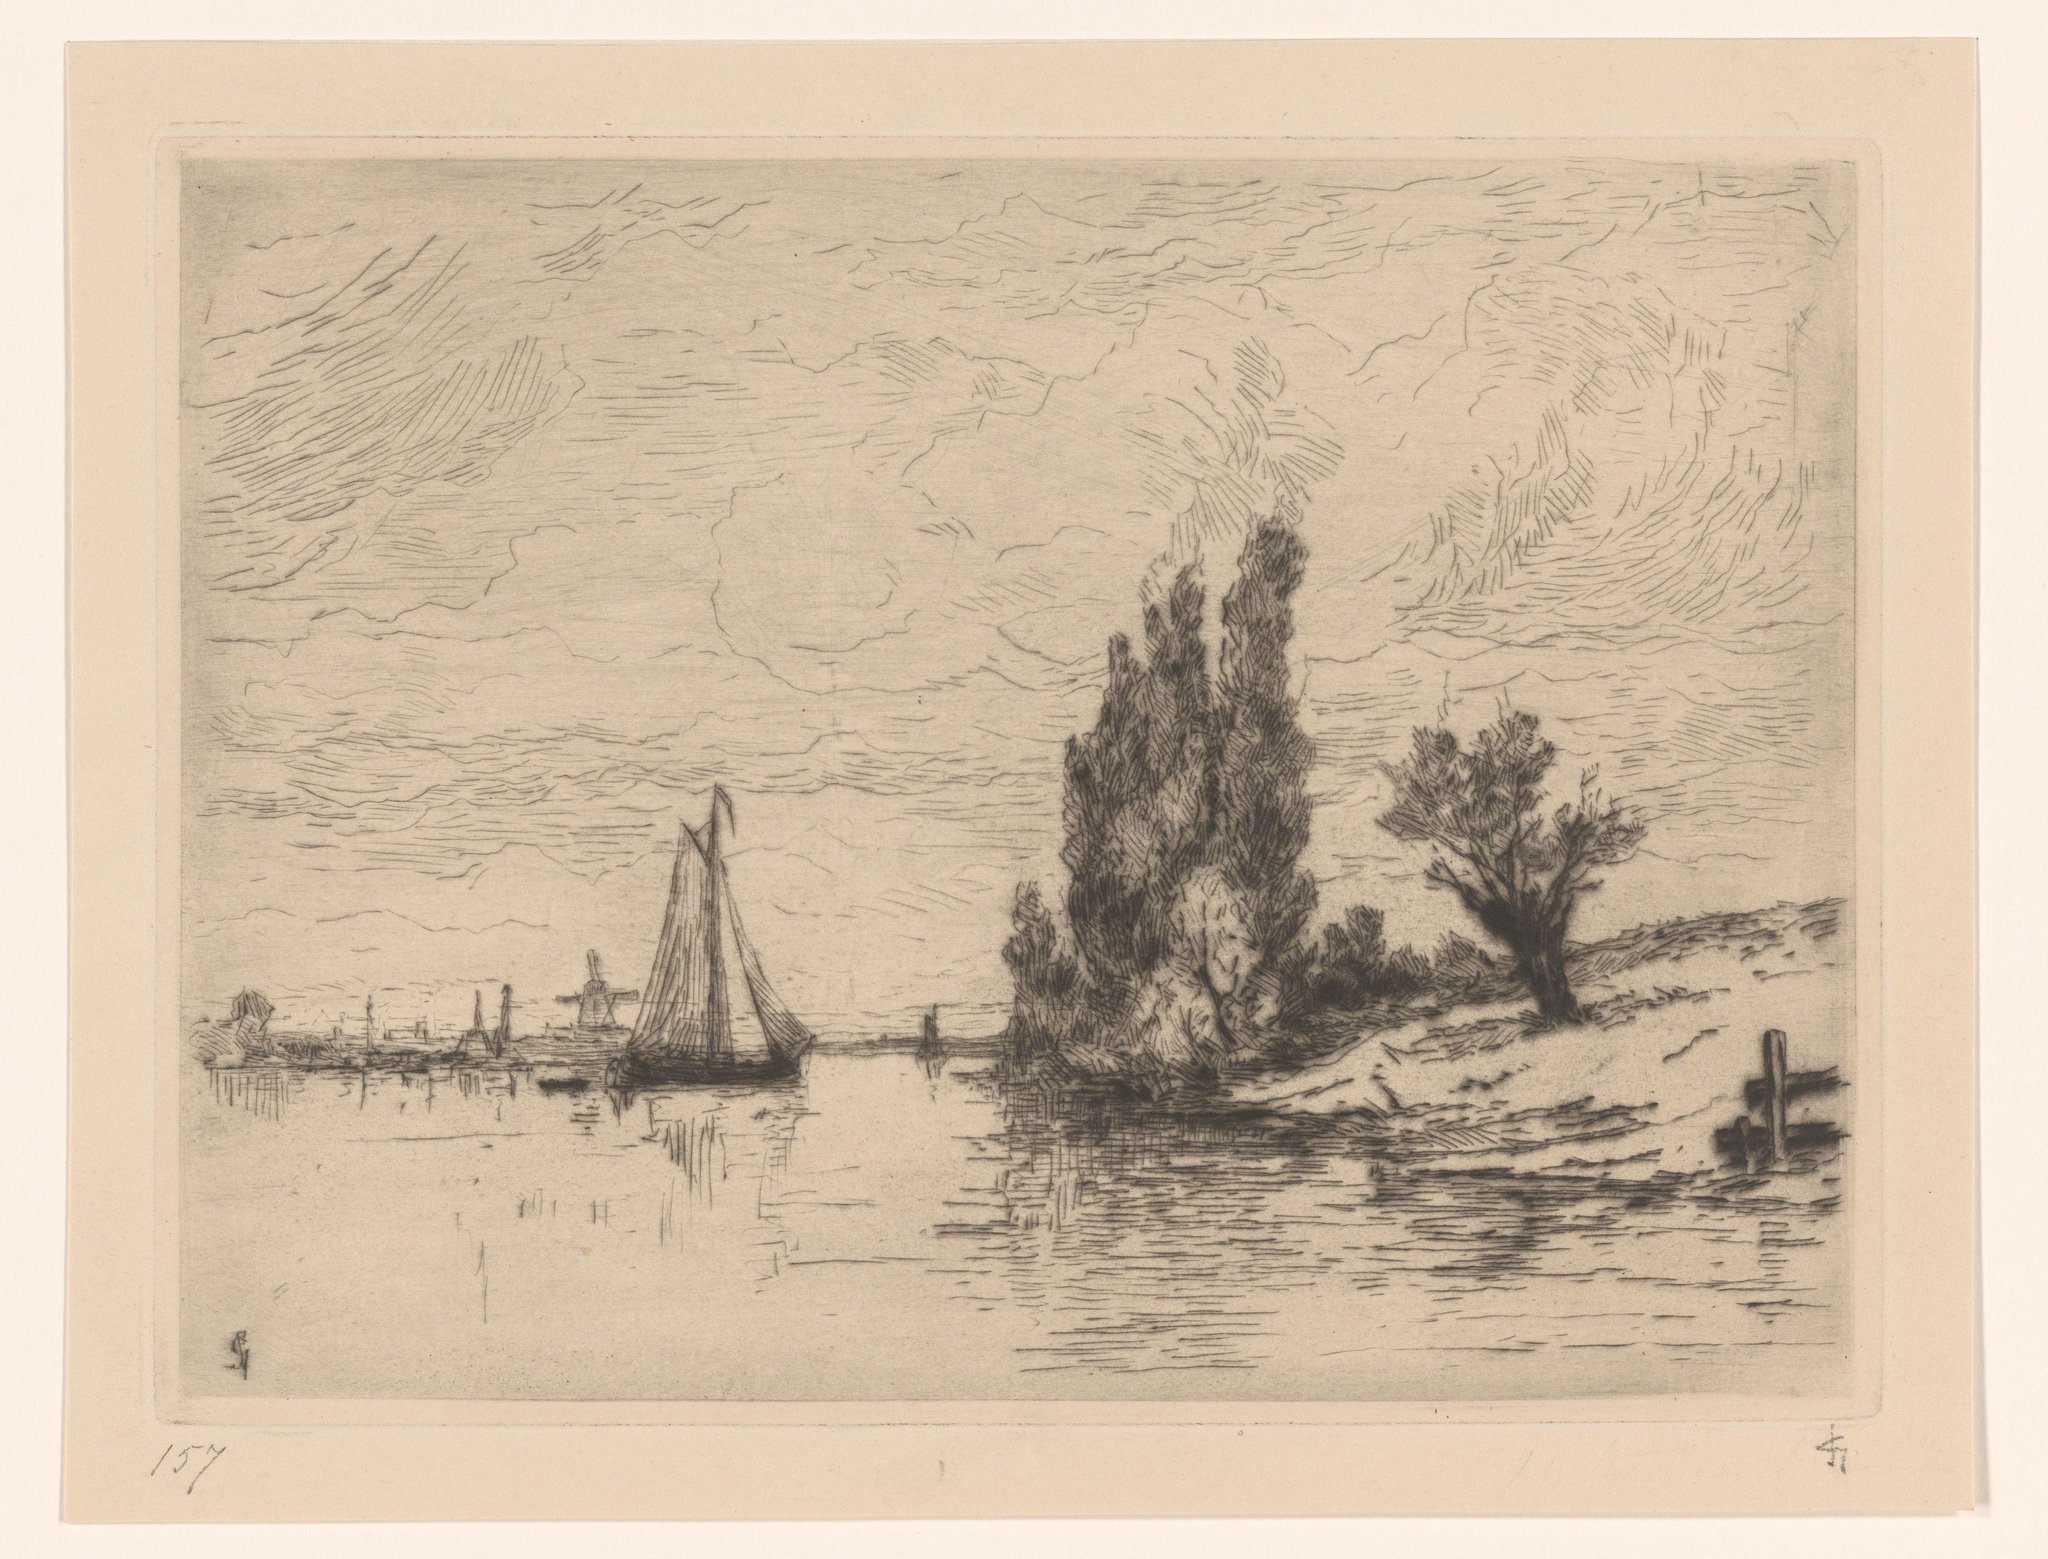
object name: print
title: Oevers van de IJssel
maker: carel nicolaas storm van s-gravesande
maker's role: draughtsman, print maker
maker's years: 1841-1924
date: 1880-1884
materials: paper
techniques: drypoint, intaglio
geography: netherlands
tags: sailing-ship, sailing-boat, river bank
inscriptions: collector's mark: Lugt 2228